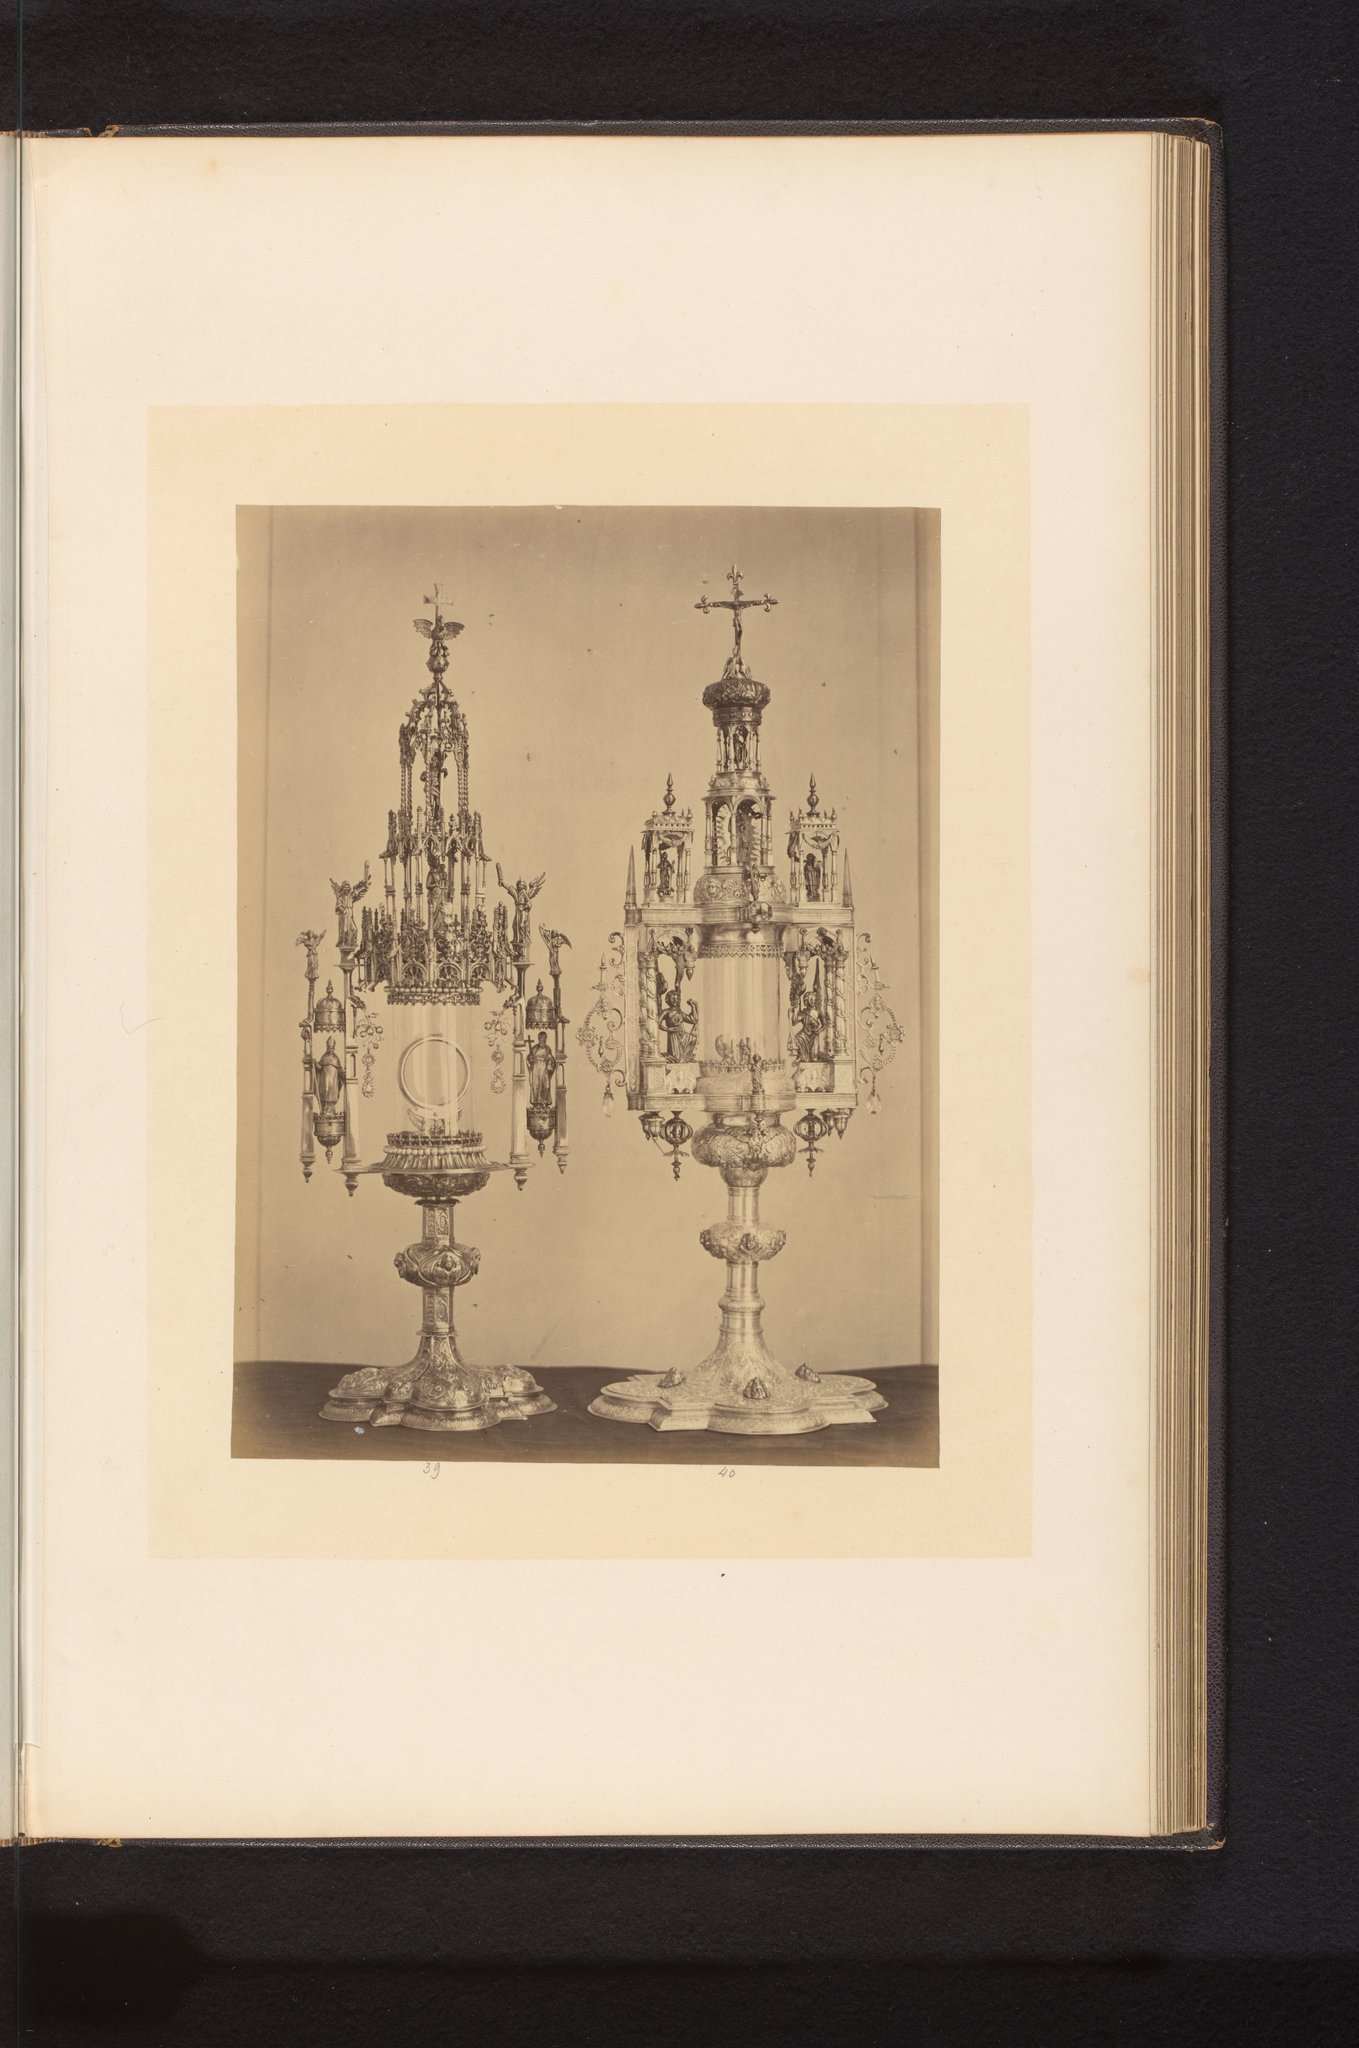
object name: page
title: Twee vergulde monstransen, opgesteld op een tentoonstelling over religieuze objecten uit de middeleeuwen en renaissance in 1864 in Mechelen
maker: joseph maes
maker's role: fotograaf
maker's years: 1838-1908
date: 1864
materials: photographic support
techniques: albumen print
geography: mechelen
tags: ostensorium, monstrance, mechelen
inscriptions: number: ‘39 - 40’